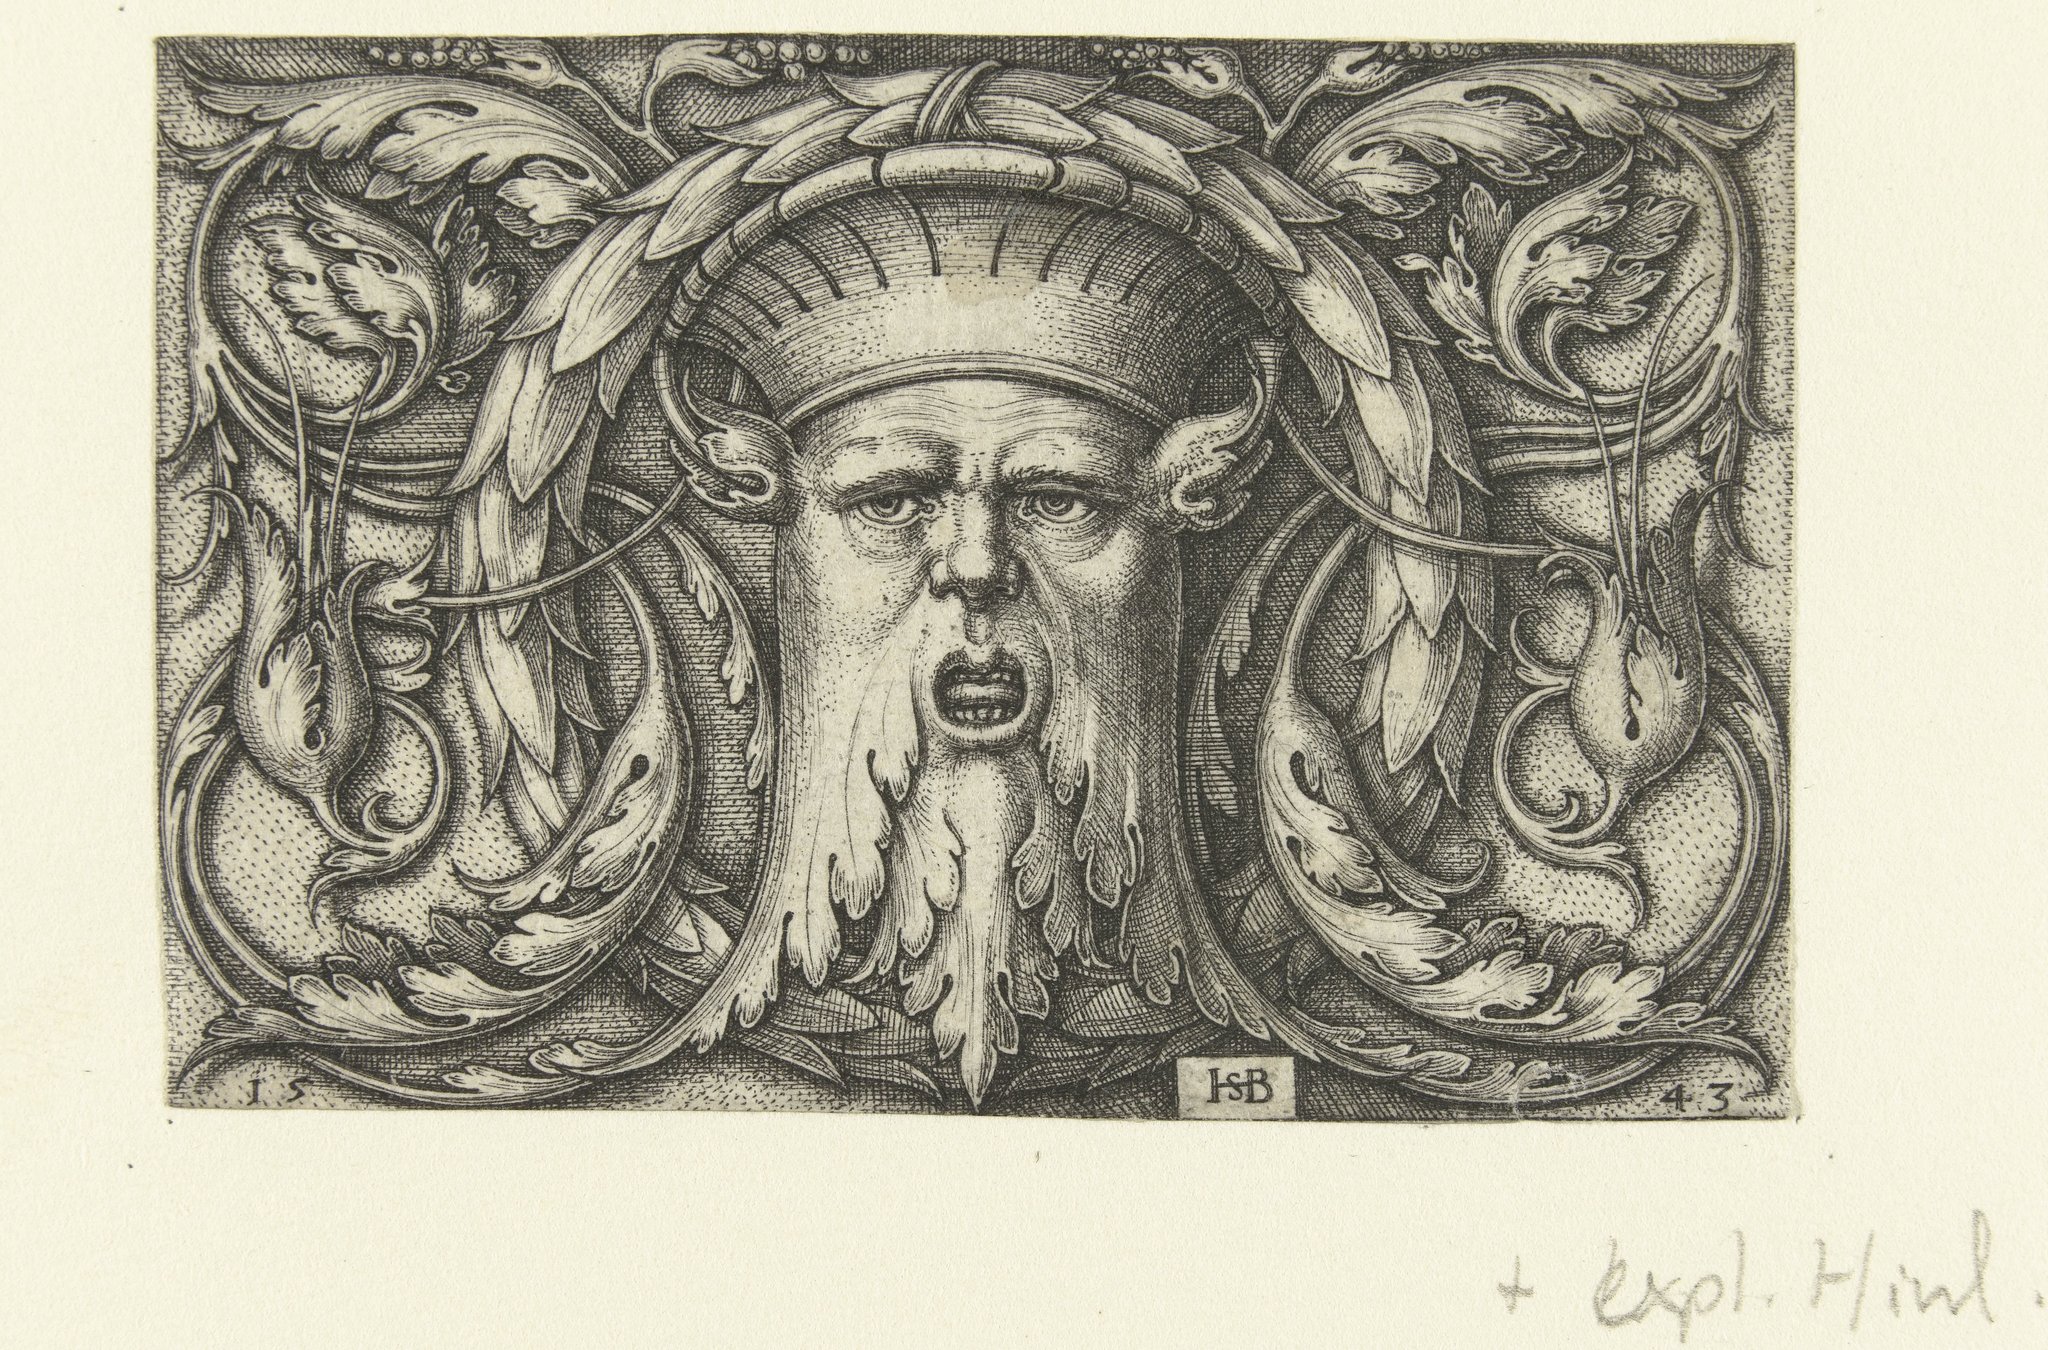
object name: print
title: Vlakdecoratie. Masker met een kroon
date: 1510-1543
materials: paper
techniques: engraving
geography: germany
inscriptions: inscription: ‘+ expl. Hinl.’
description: Masker in een krans van laurierbladeren, omgeven door bladranken. Gearceerde achtergrond.